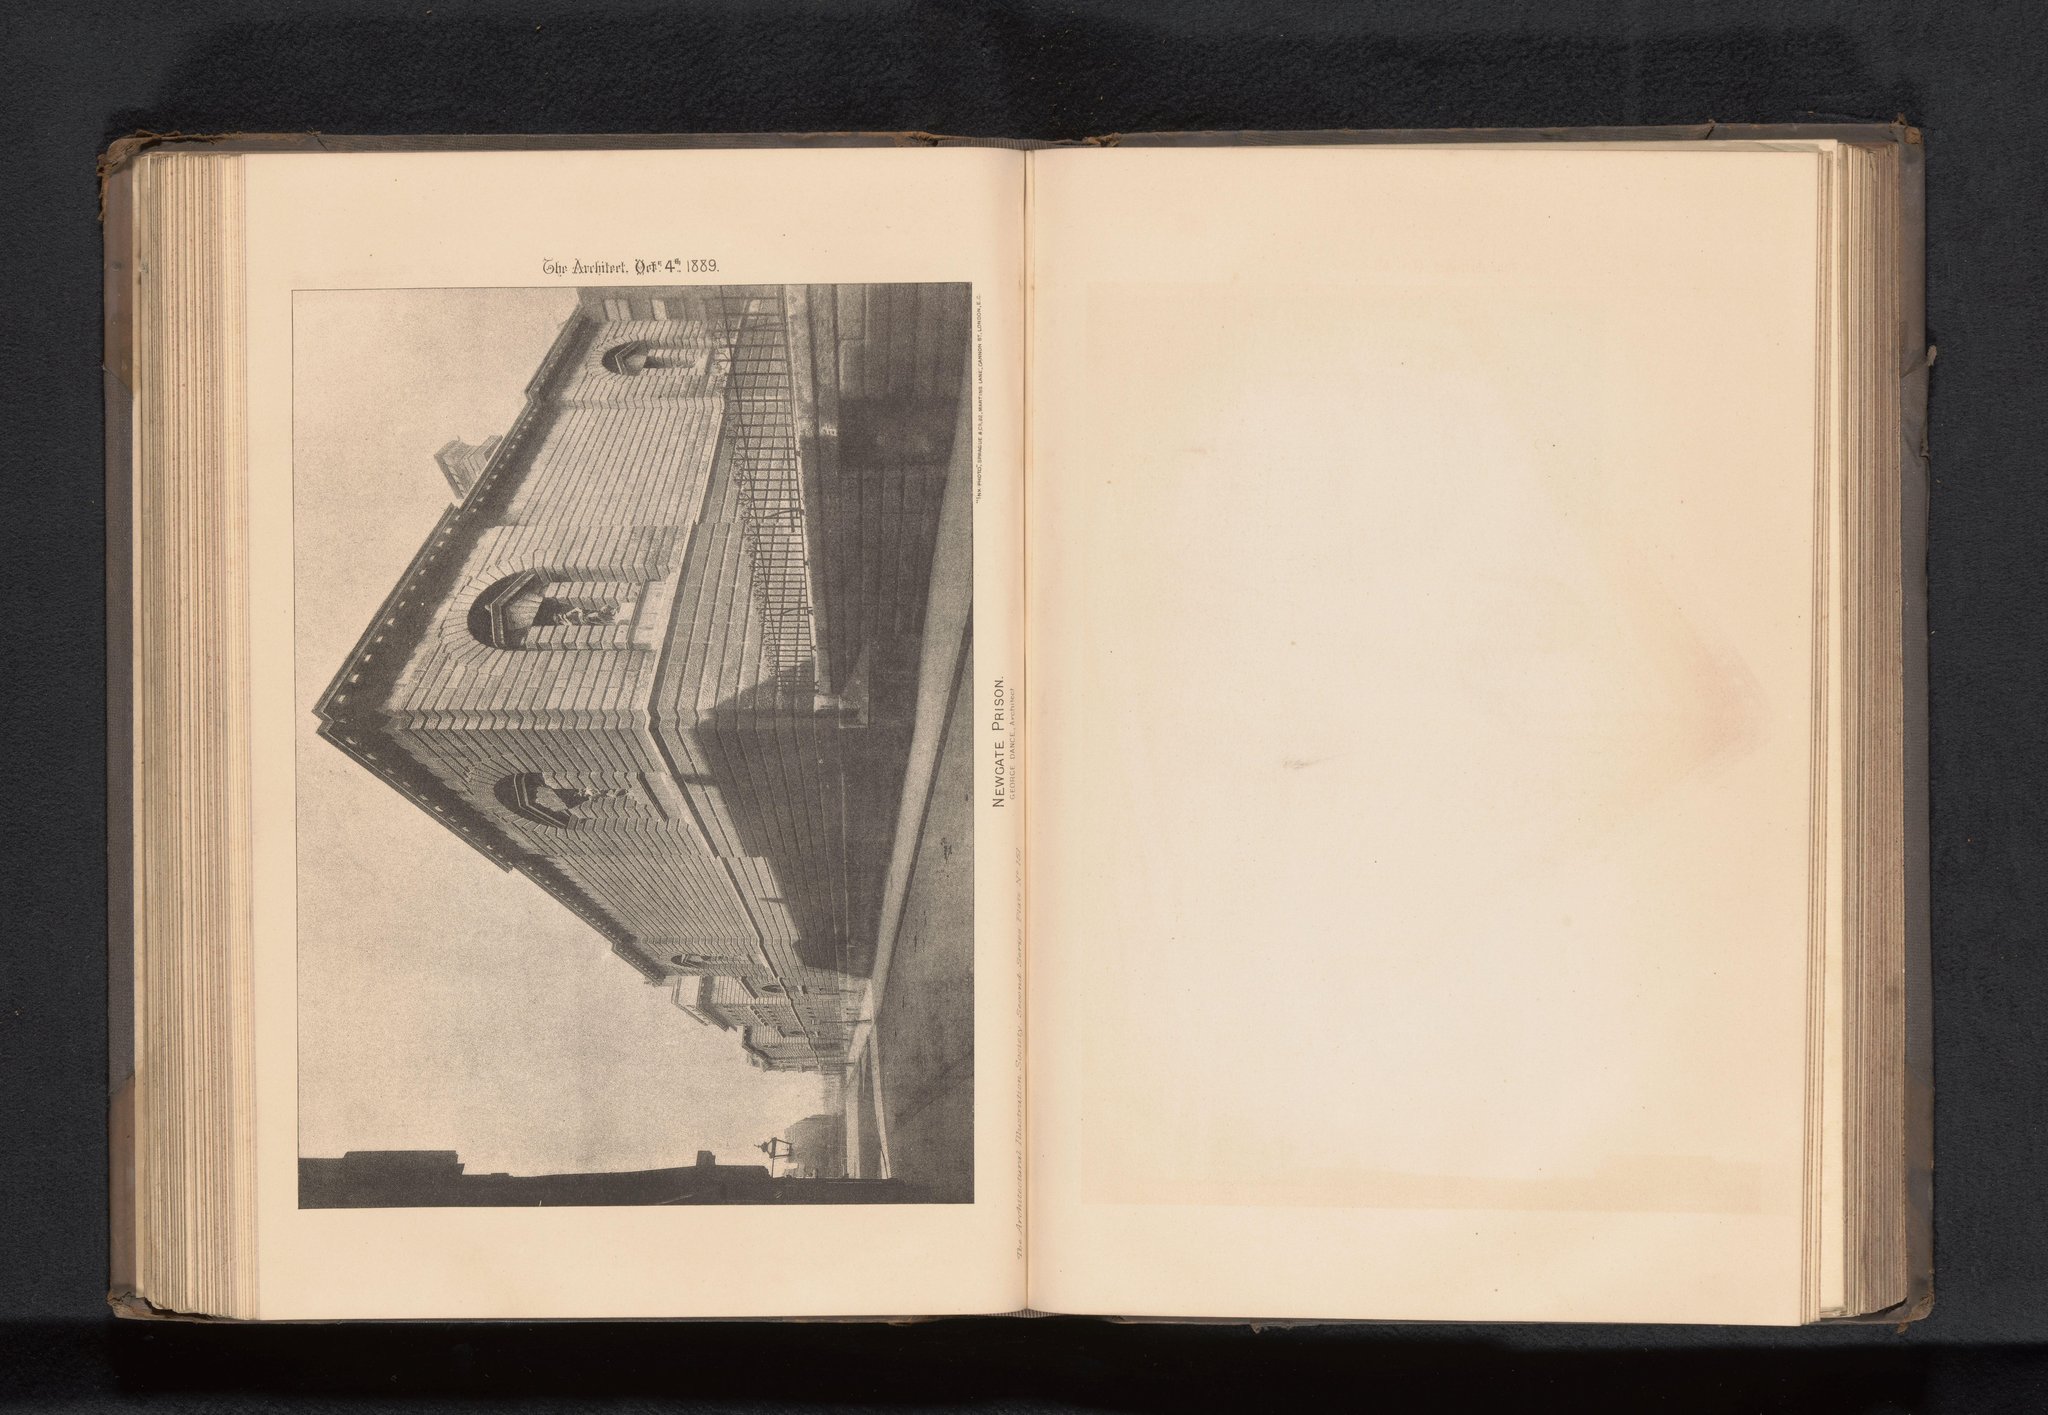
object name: photomechanical print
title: Gezicht op de Newgate Prison te Londen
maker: Anonymous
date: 1884-1889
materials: paper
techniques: photolithography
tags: prison, jail, london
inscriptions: inscription: ‘George Dance, Architect/ Architectural Illustration Society. Second Series. Plate No.151’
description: Prent op zesde ongenummerde pagina na pagina 194.